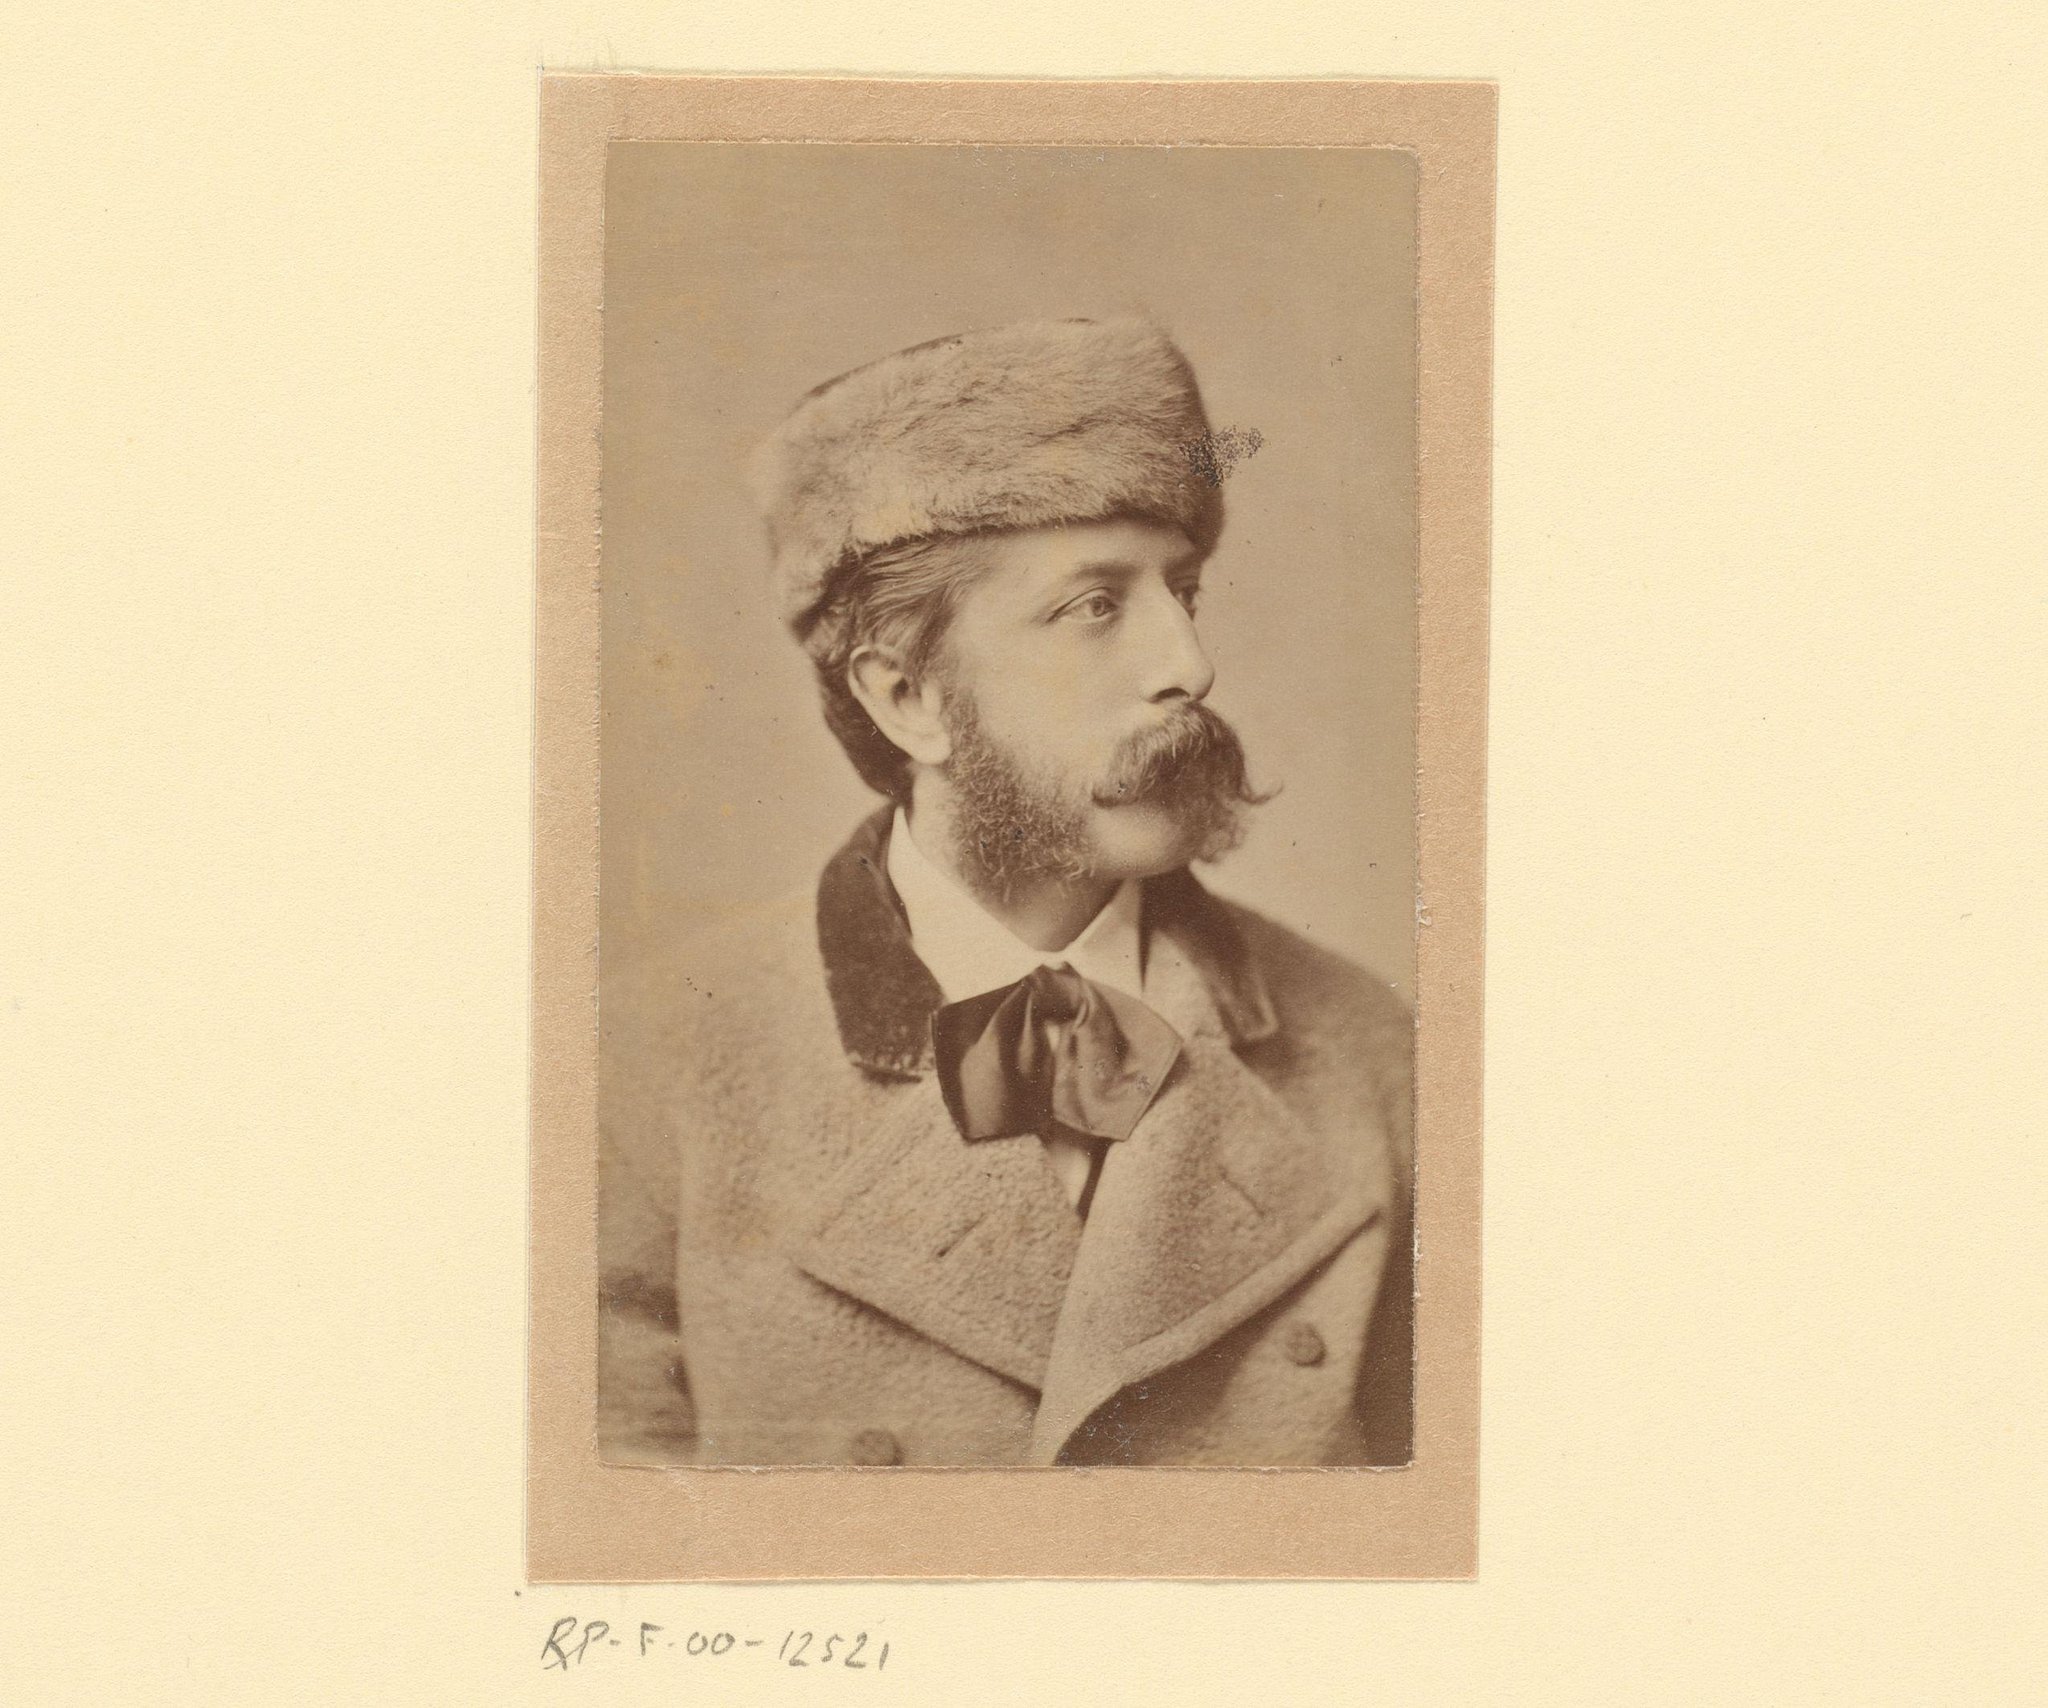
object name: photograph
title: Portret van Willem Johann Martens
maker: Anonymous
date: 1860-1880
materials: cardboard, paper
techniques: albumen print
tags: amsterdam, draughtsman, willem johann martens, historical persons